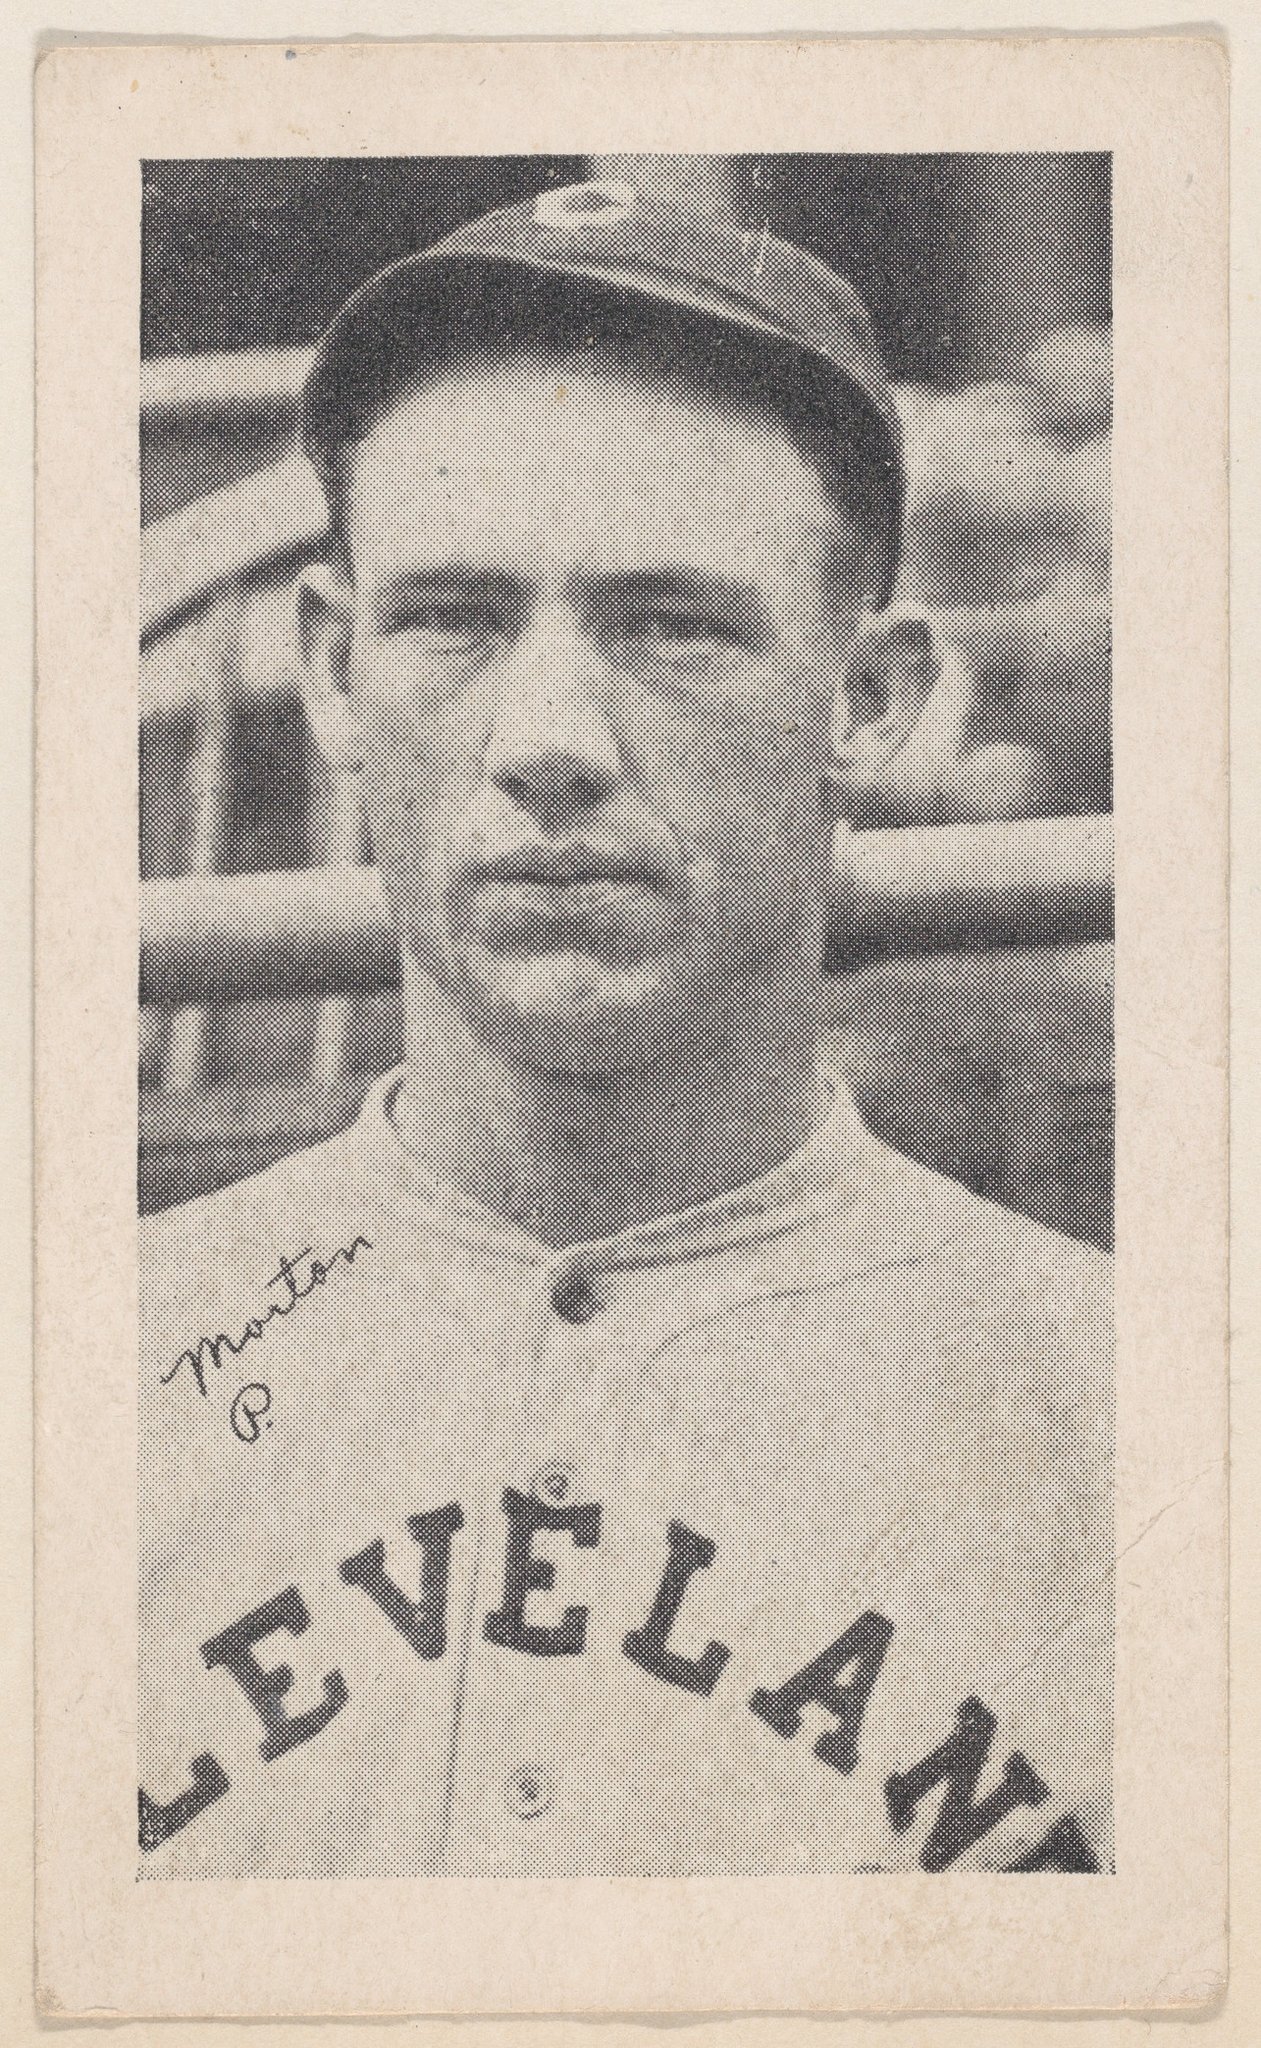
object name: print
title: Morton, P., from Baseball strip cards (W575-2)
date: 1921-1922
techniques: photolithograph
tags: men,portraits,baseball,athletes